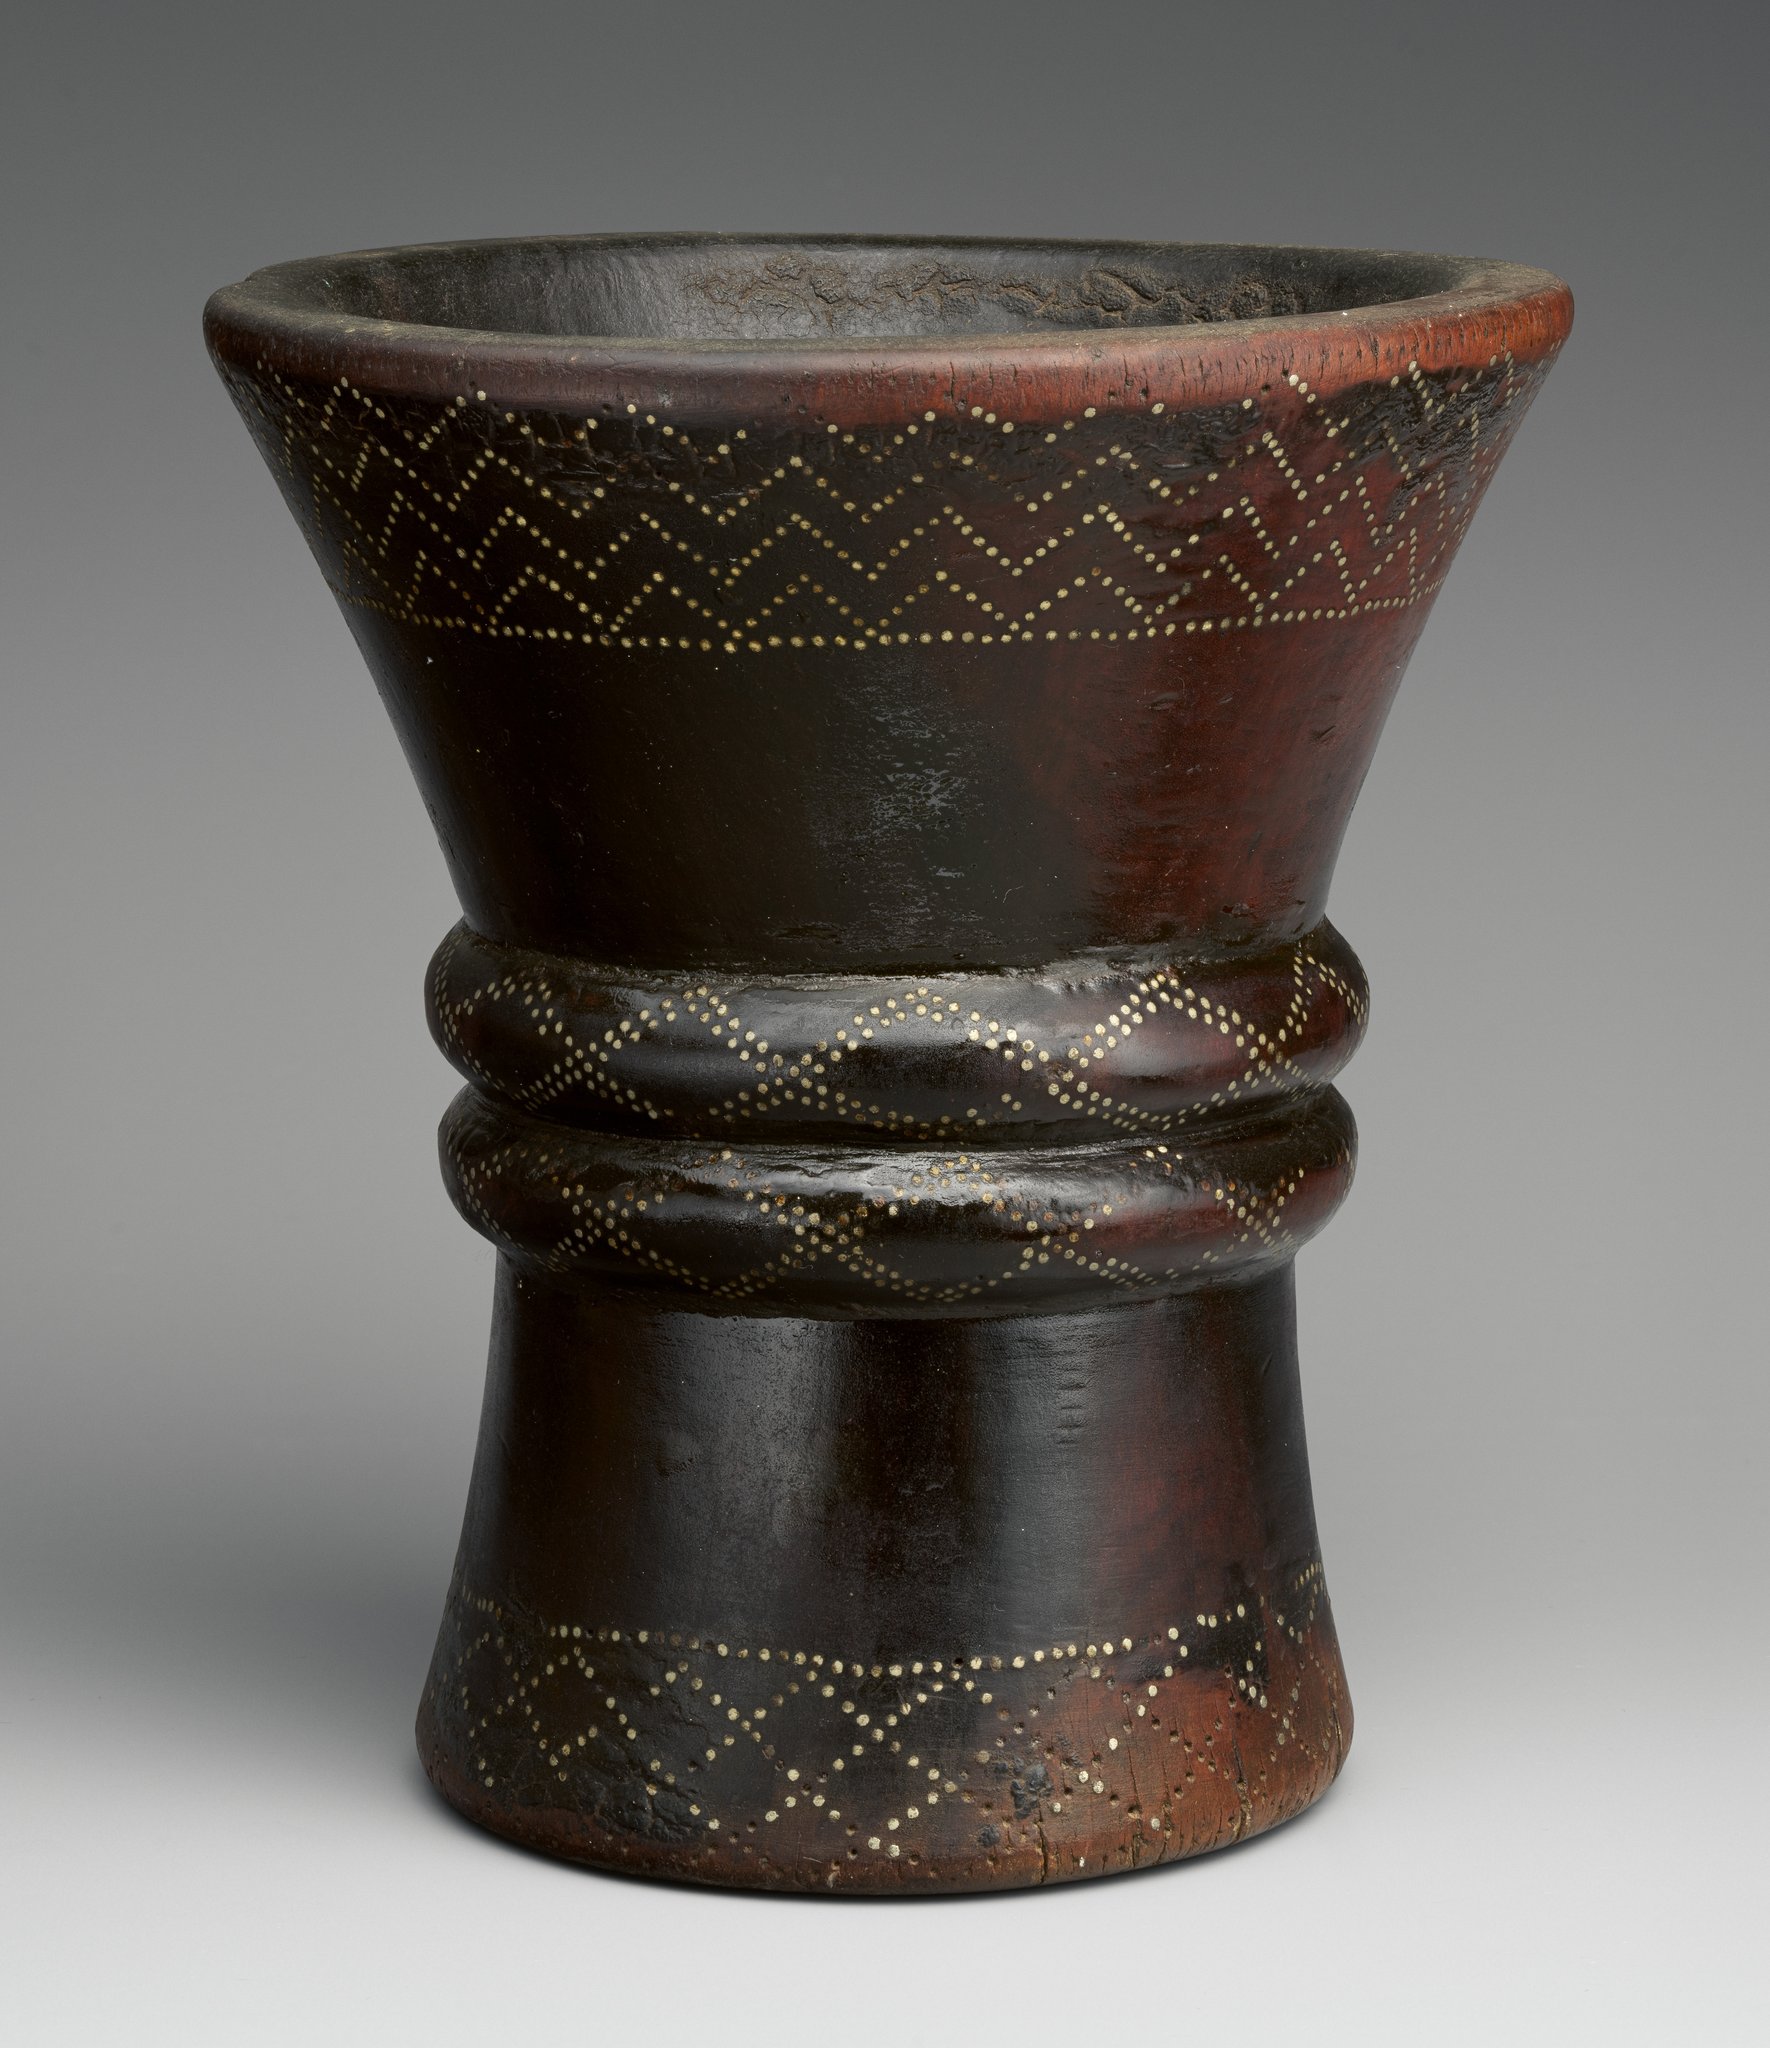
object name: kero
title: Kero (beaker)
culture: quechua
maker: peruvian artist(s)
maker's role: artist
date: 1601-1633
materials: pigment, tin, wood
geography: peru